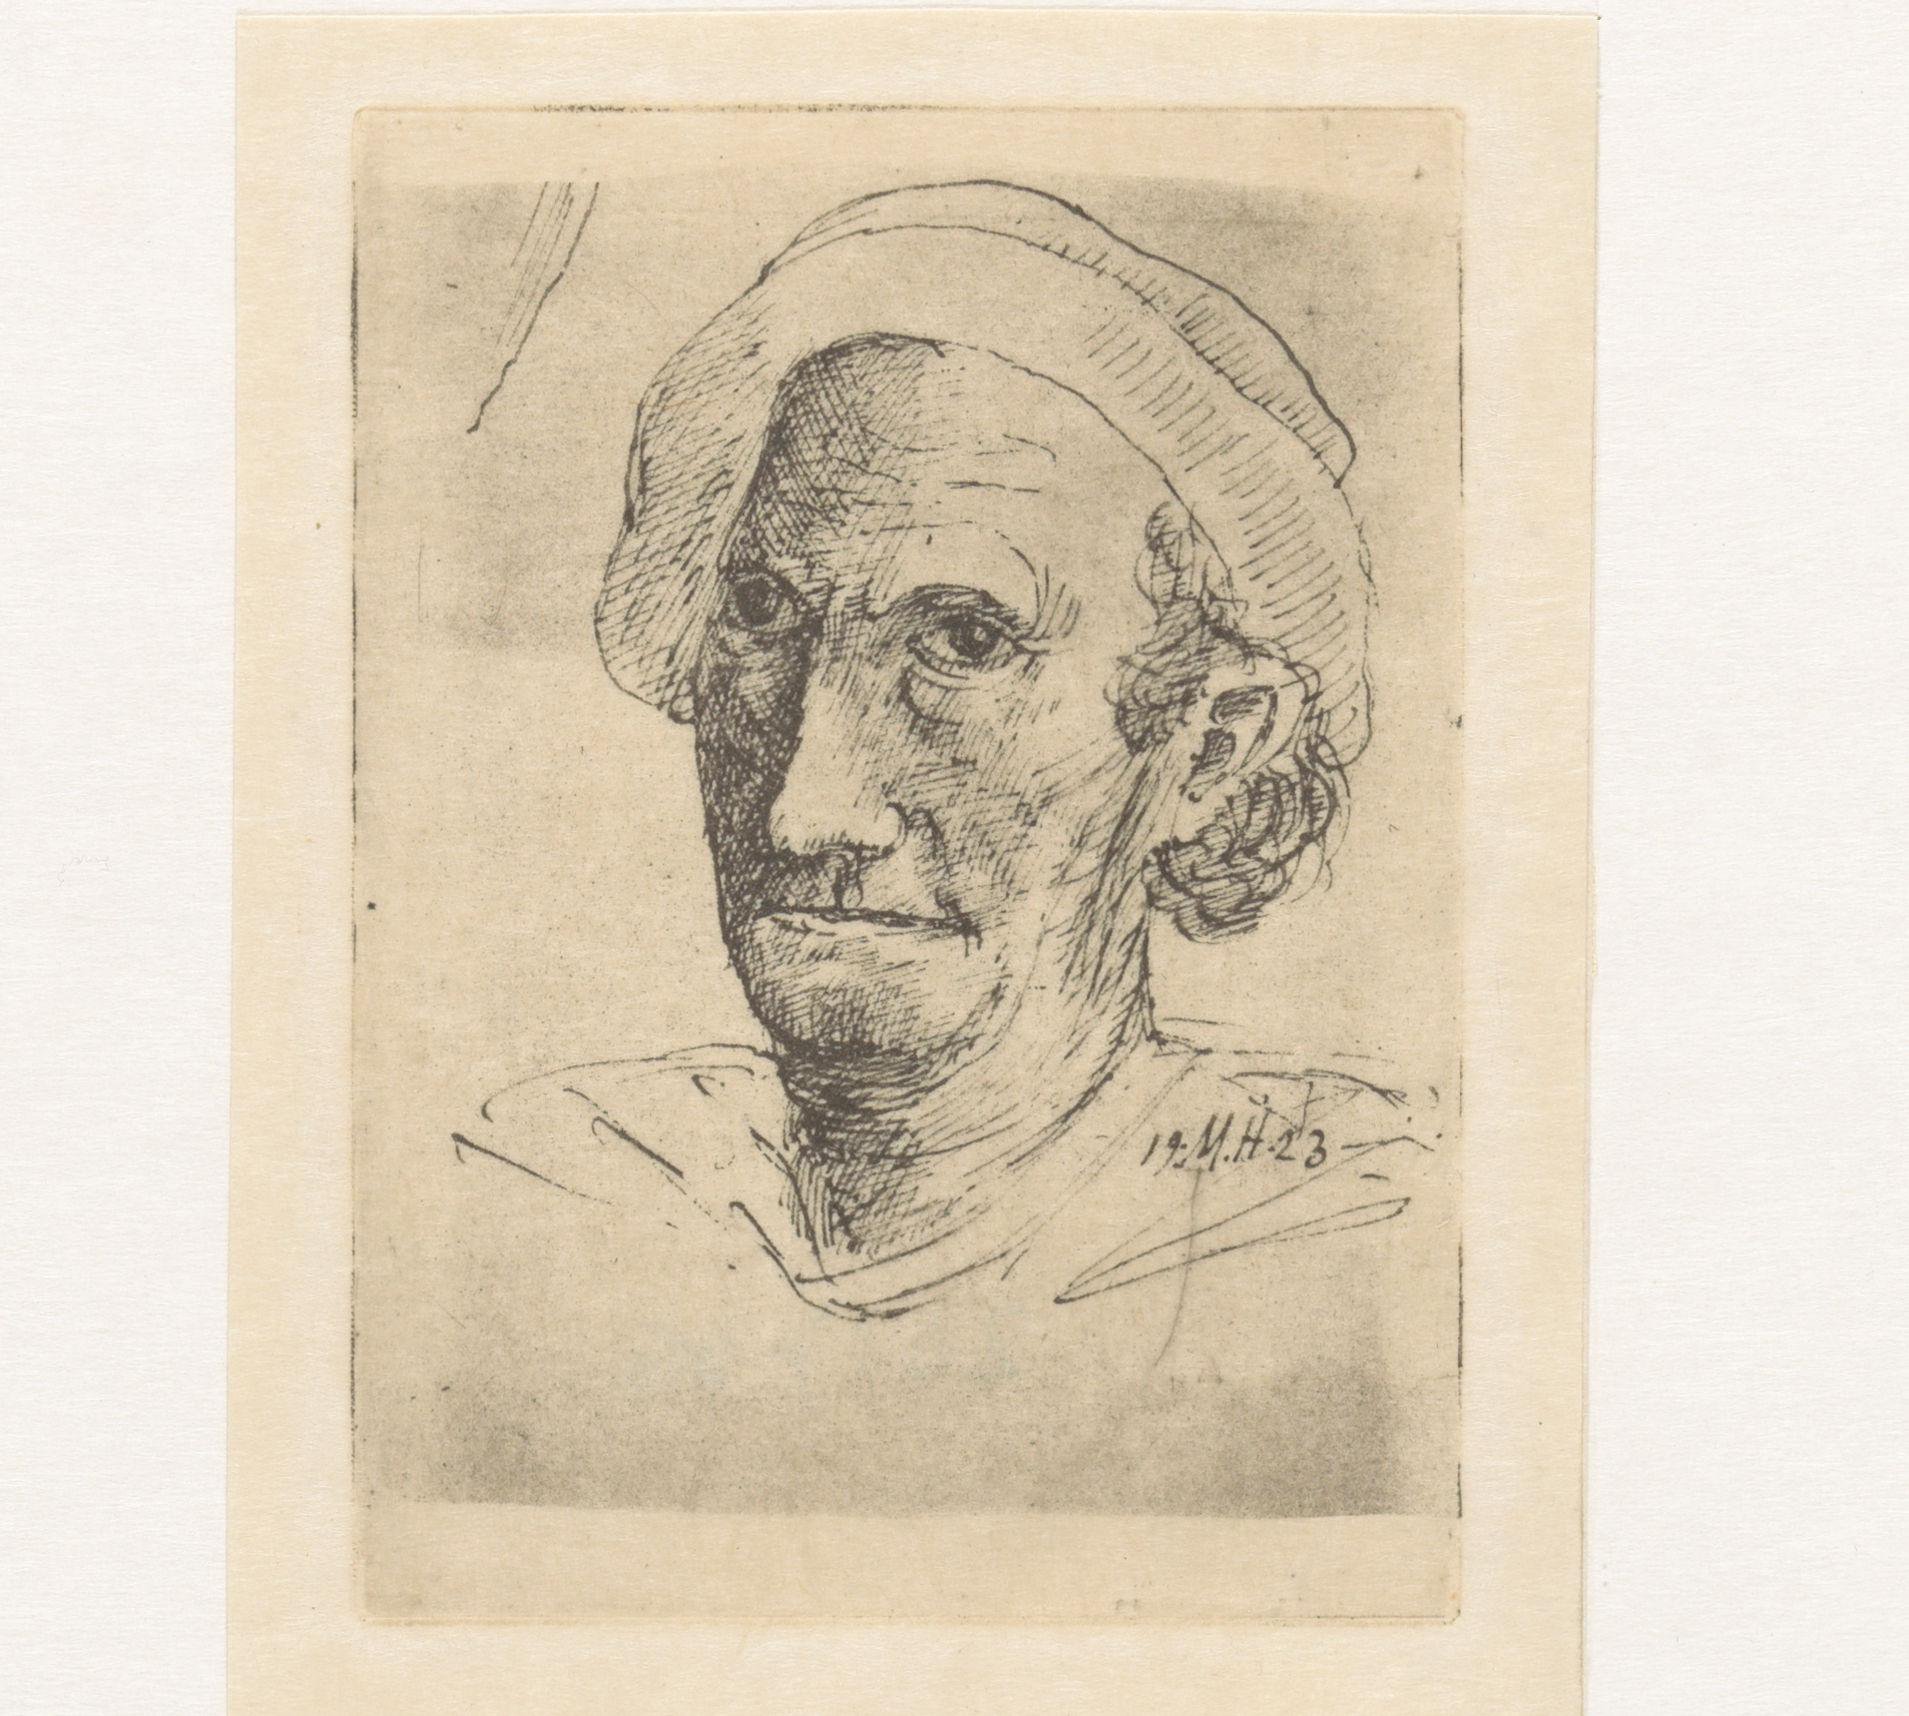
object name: print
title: Uit het leven van Bellerophon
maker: marius holleman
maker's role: draughtsman, print maker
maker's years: 1878-1926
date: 1917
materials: paper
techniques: etching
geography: groningen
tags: pegasus, the winged horse, suffering, misfortune of bellerophon, blind, blindness, dog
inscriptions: collector's mark: Lugt 2228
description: Bij de deur van het huis staan twee vrouwen toe te kijken. Op de voorgrond twee honden.